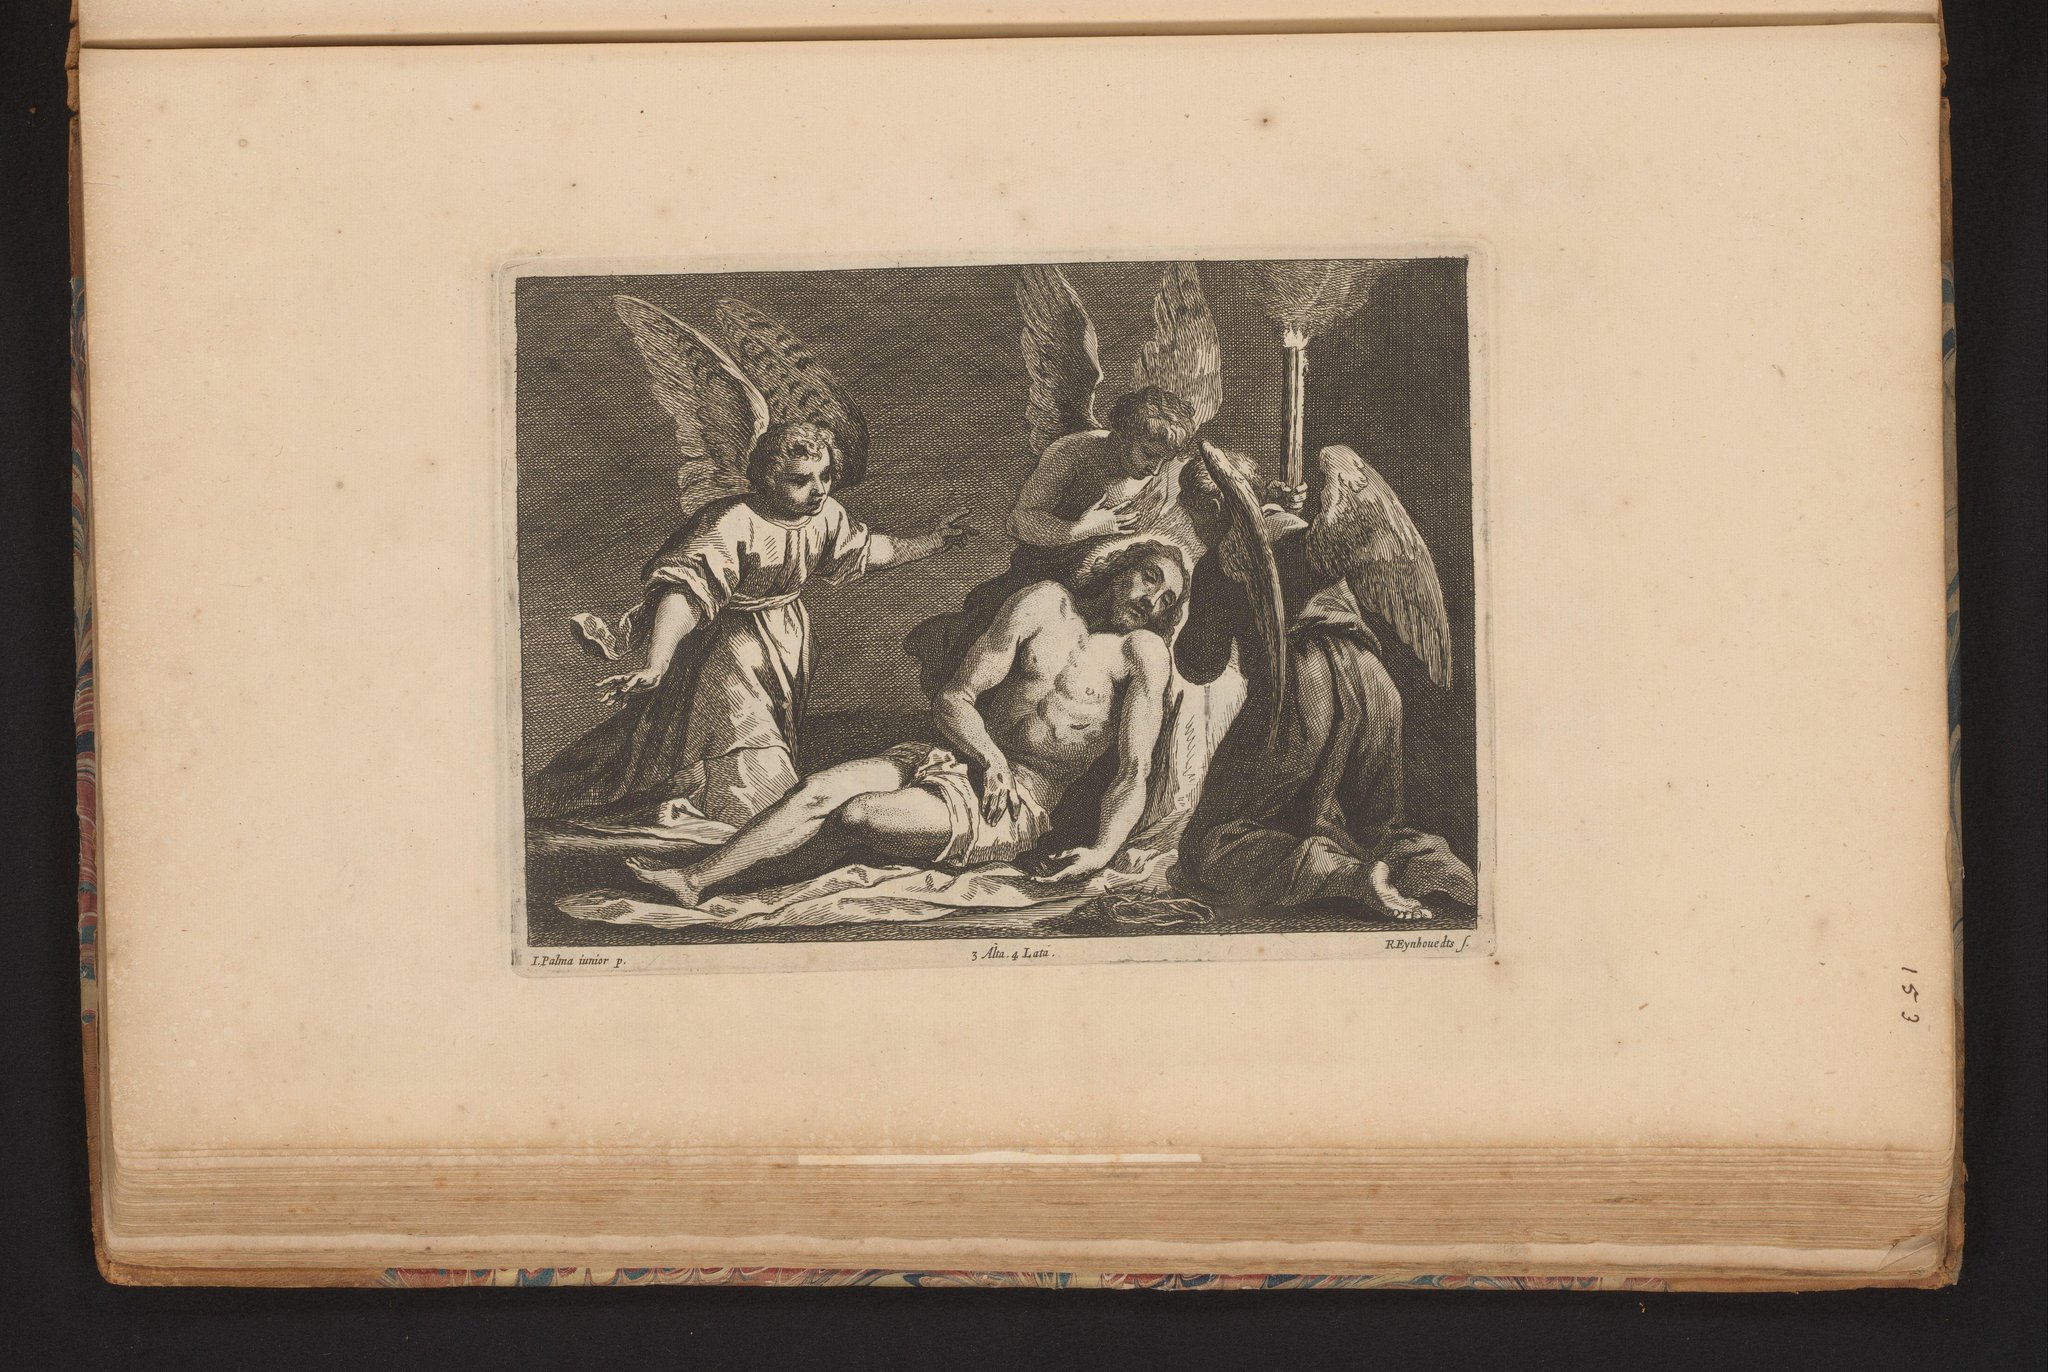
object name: album leaf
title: Bewening van Christus door drie engelen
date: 1660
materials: paper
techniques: engraving, etching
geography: antwerp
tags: christ lamented by angels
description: David Teniers heeft waarschijnlijk van alle schilderijen uit de collectie van Leopold Willem van Oostenrijk een olieverfstudie op doek of paneel vervaardigd (zgn. pasticcio), die als voorbeeld voor de prentmakers diende. Het is niet altijd duidelijk of de pasticci door hem zijn gemaakt of door zijn atelier. Niet alle pasticci zijn overgeleverd.